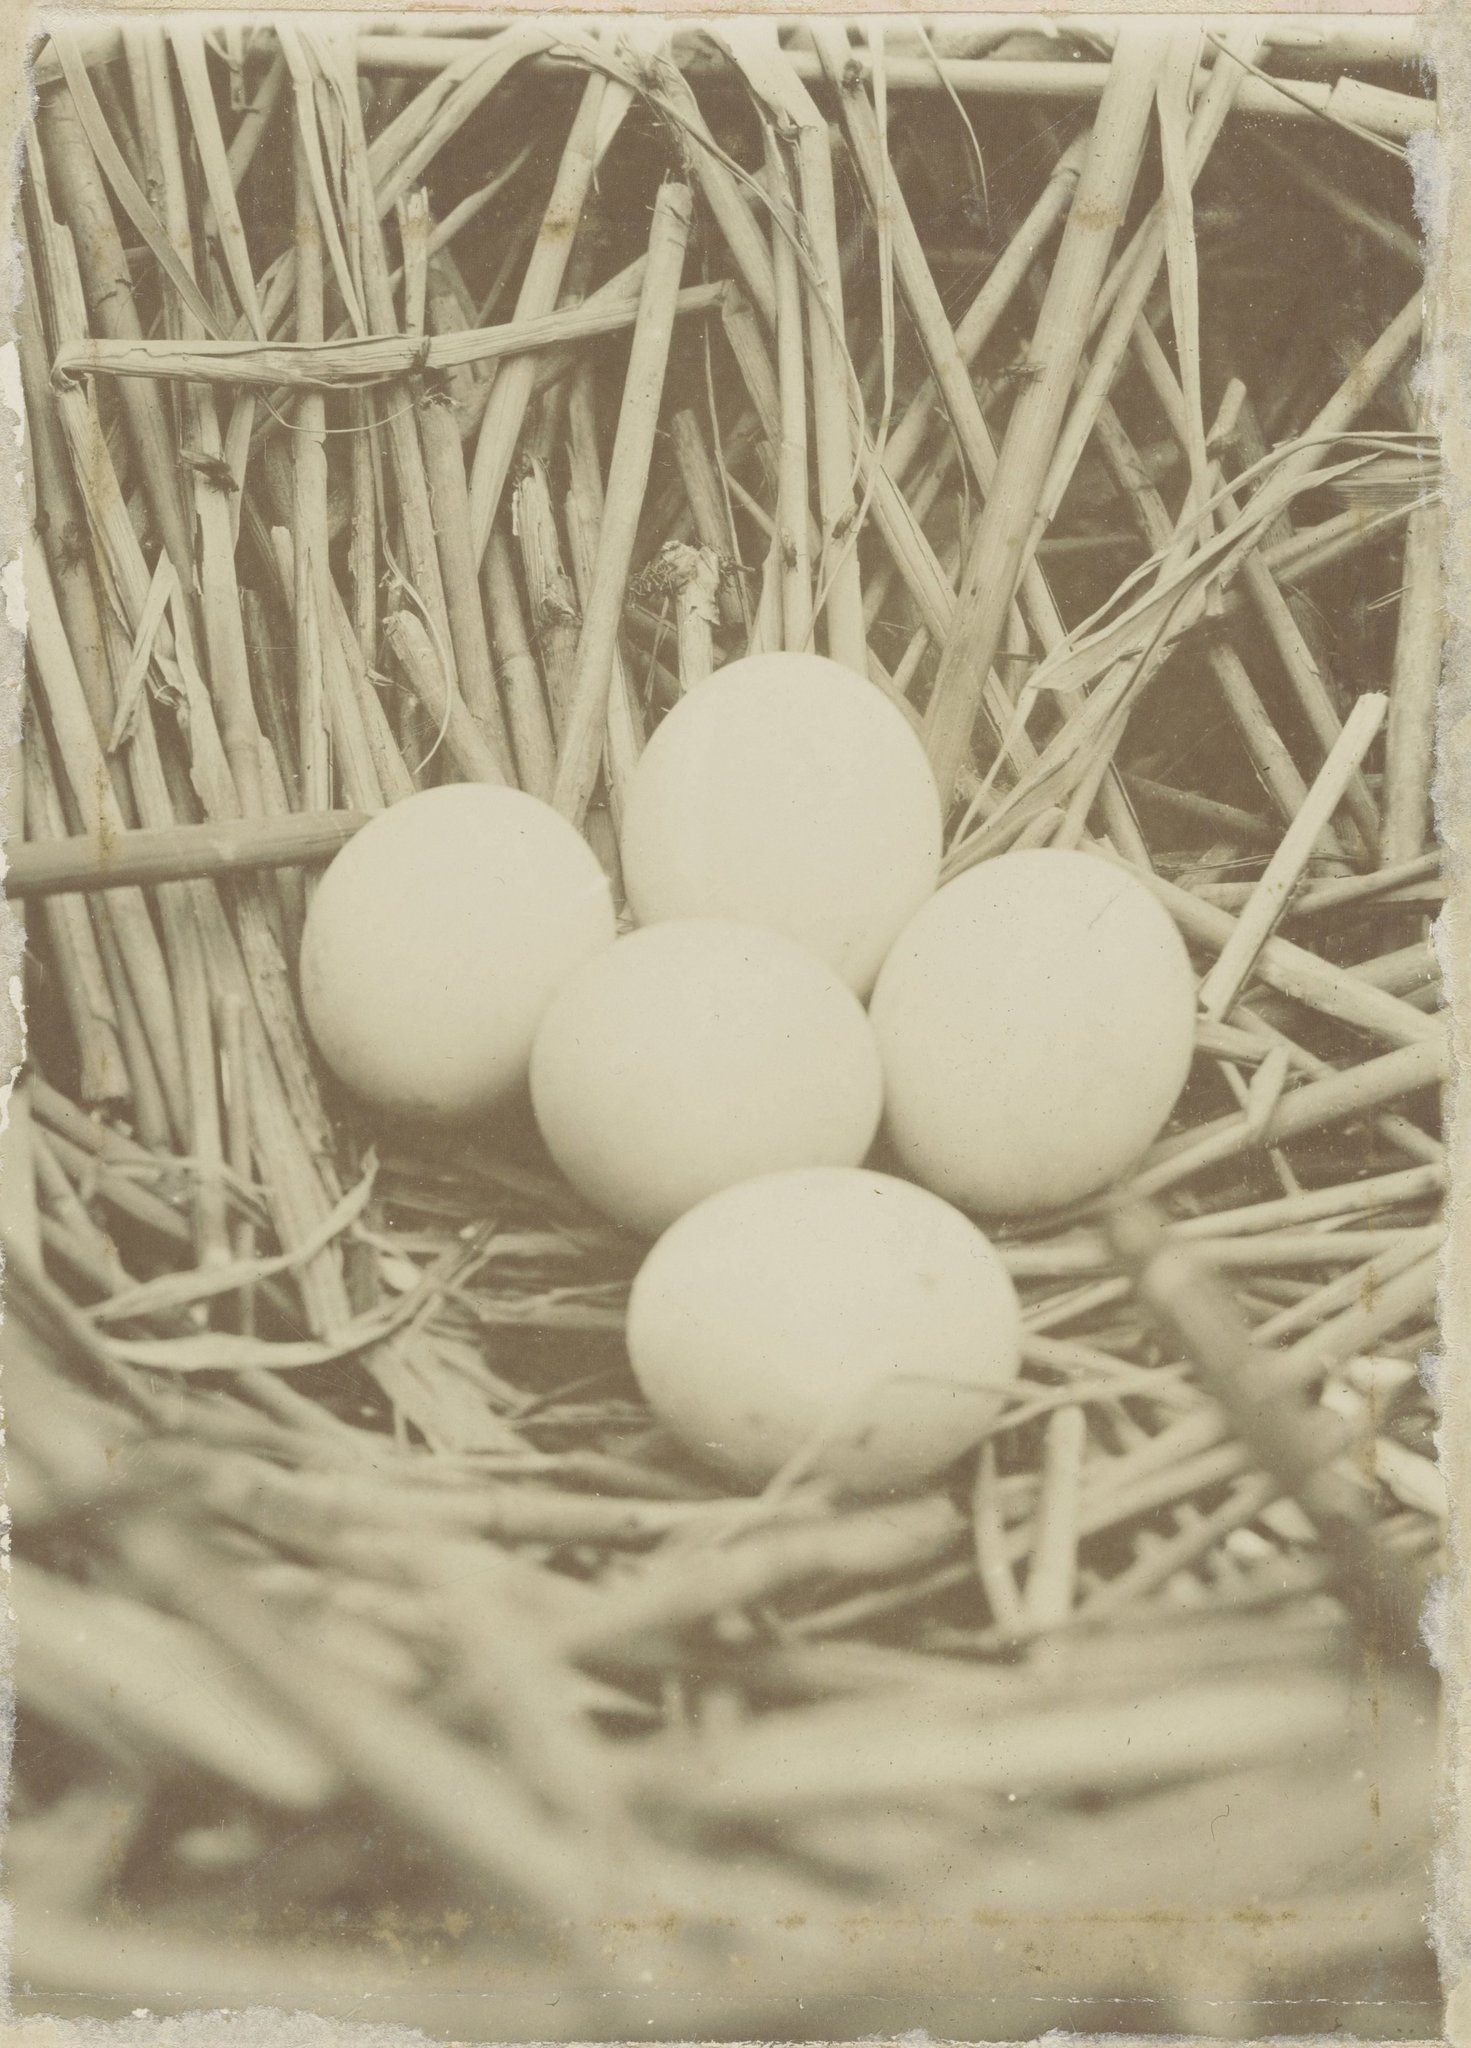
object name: photograph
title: Nest èn Eieren van den Purpurreiger Hallo's Matpapier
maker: richard tepe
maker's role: fotograaf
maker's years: 1864-1952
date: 1900-1930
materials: paper, cardboard, photographic support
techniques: collodion silver print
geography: netherlands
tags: nesting-box (+ variant)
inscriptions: annotation: ‘Nest èn Eieren van den Purpurreiger Hallo's Matpapier’, signature: ‘foto R Tepe’